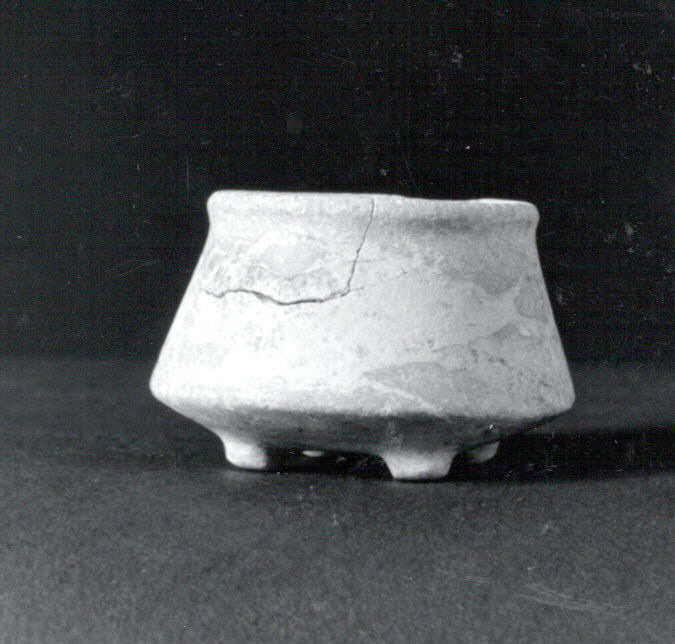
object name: bowl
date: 7000-5001 BCE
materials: limestone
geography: syria